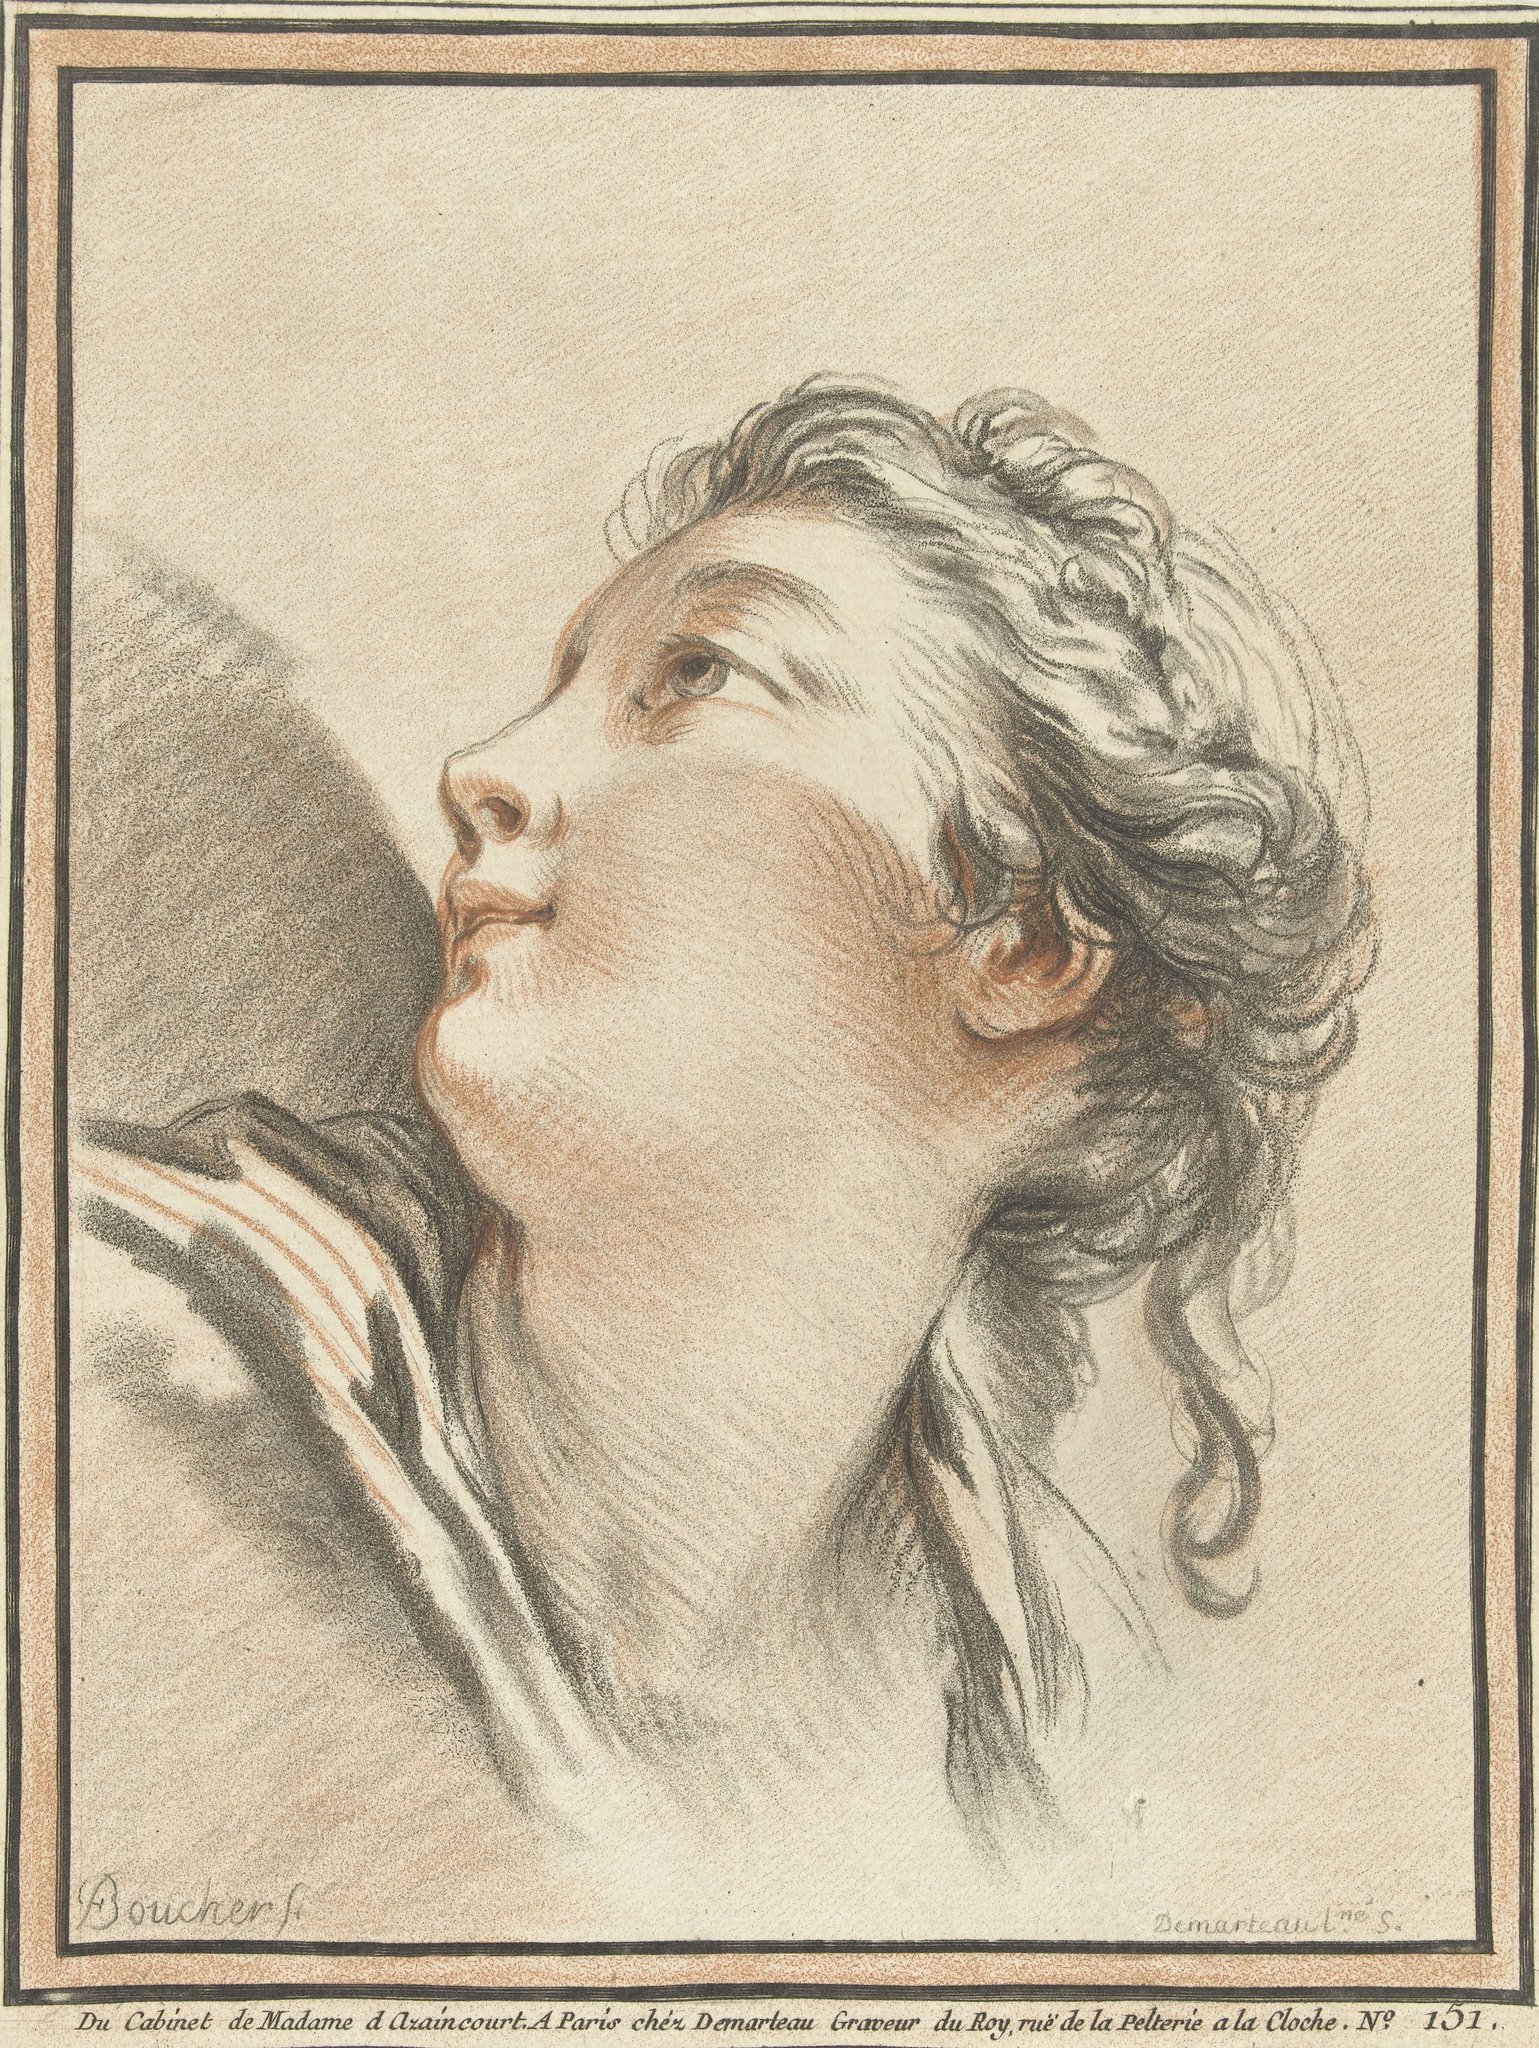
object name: print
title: Hoofd van vrouw, gedraaid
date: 1732-1776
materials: paper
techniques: printmaking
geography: paris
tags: head turned sideways - aa - female human figure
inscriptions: collector's mark: Lugt 2228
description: Prent naar tekening van Francois Boucher in collectie van mevrouw d'Azaincourt, aldus opschrift.